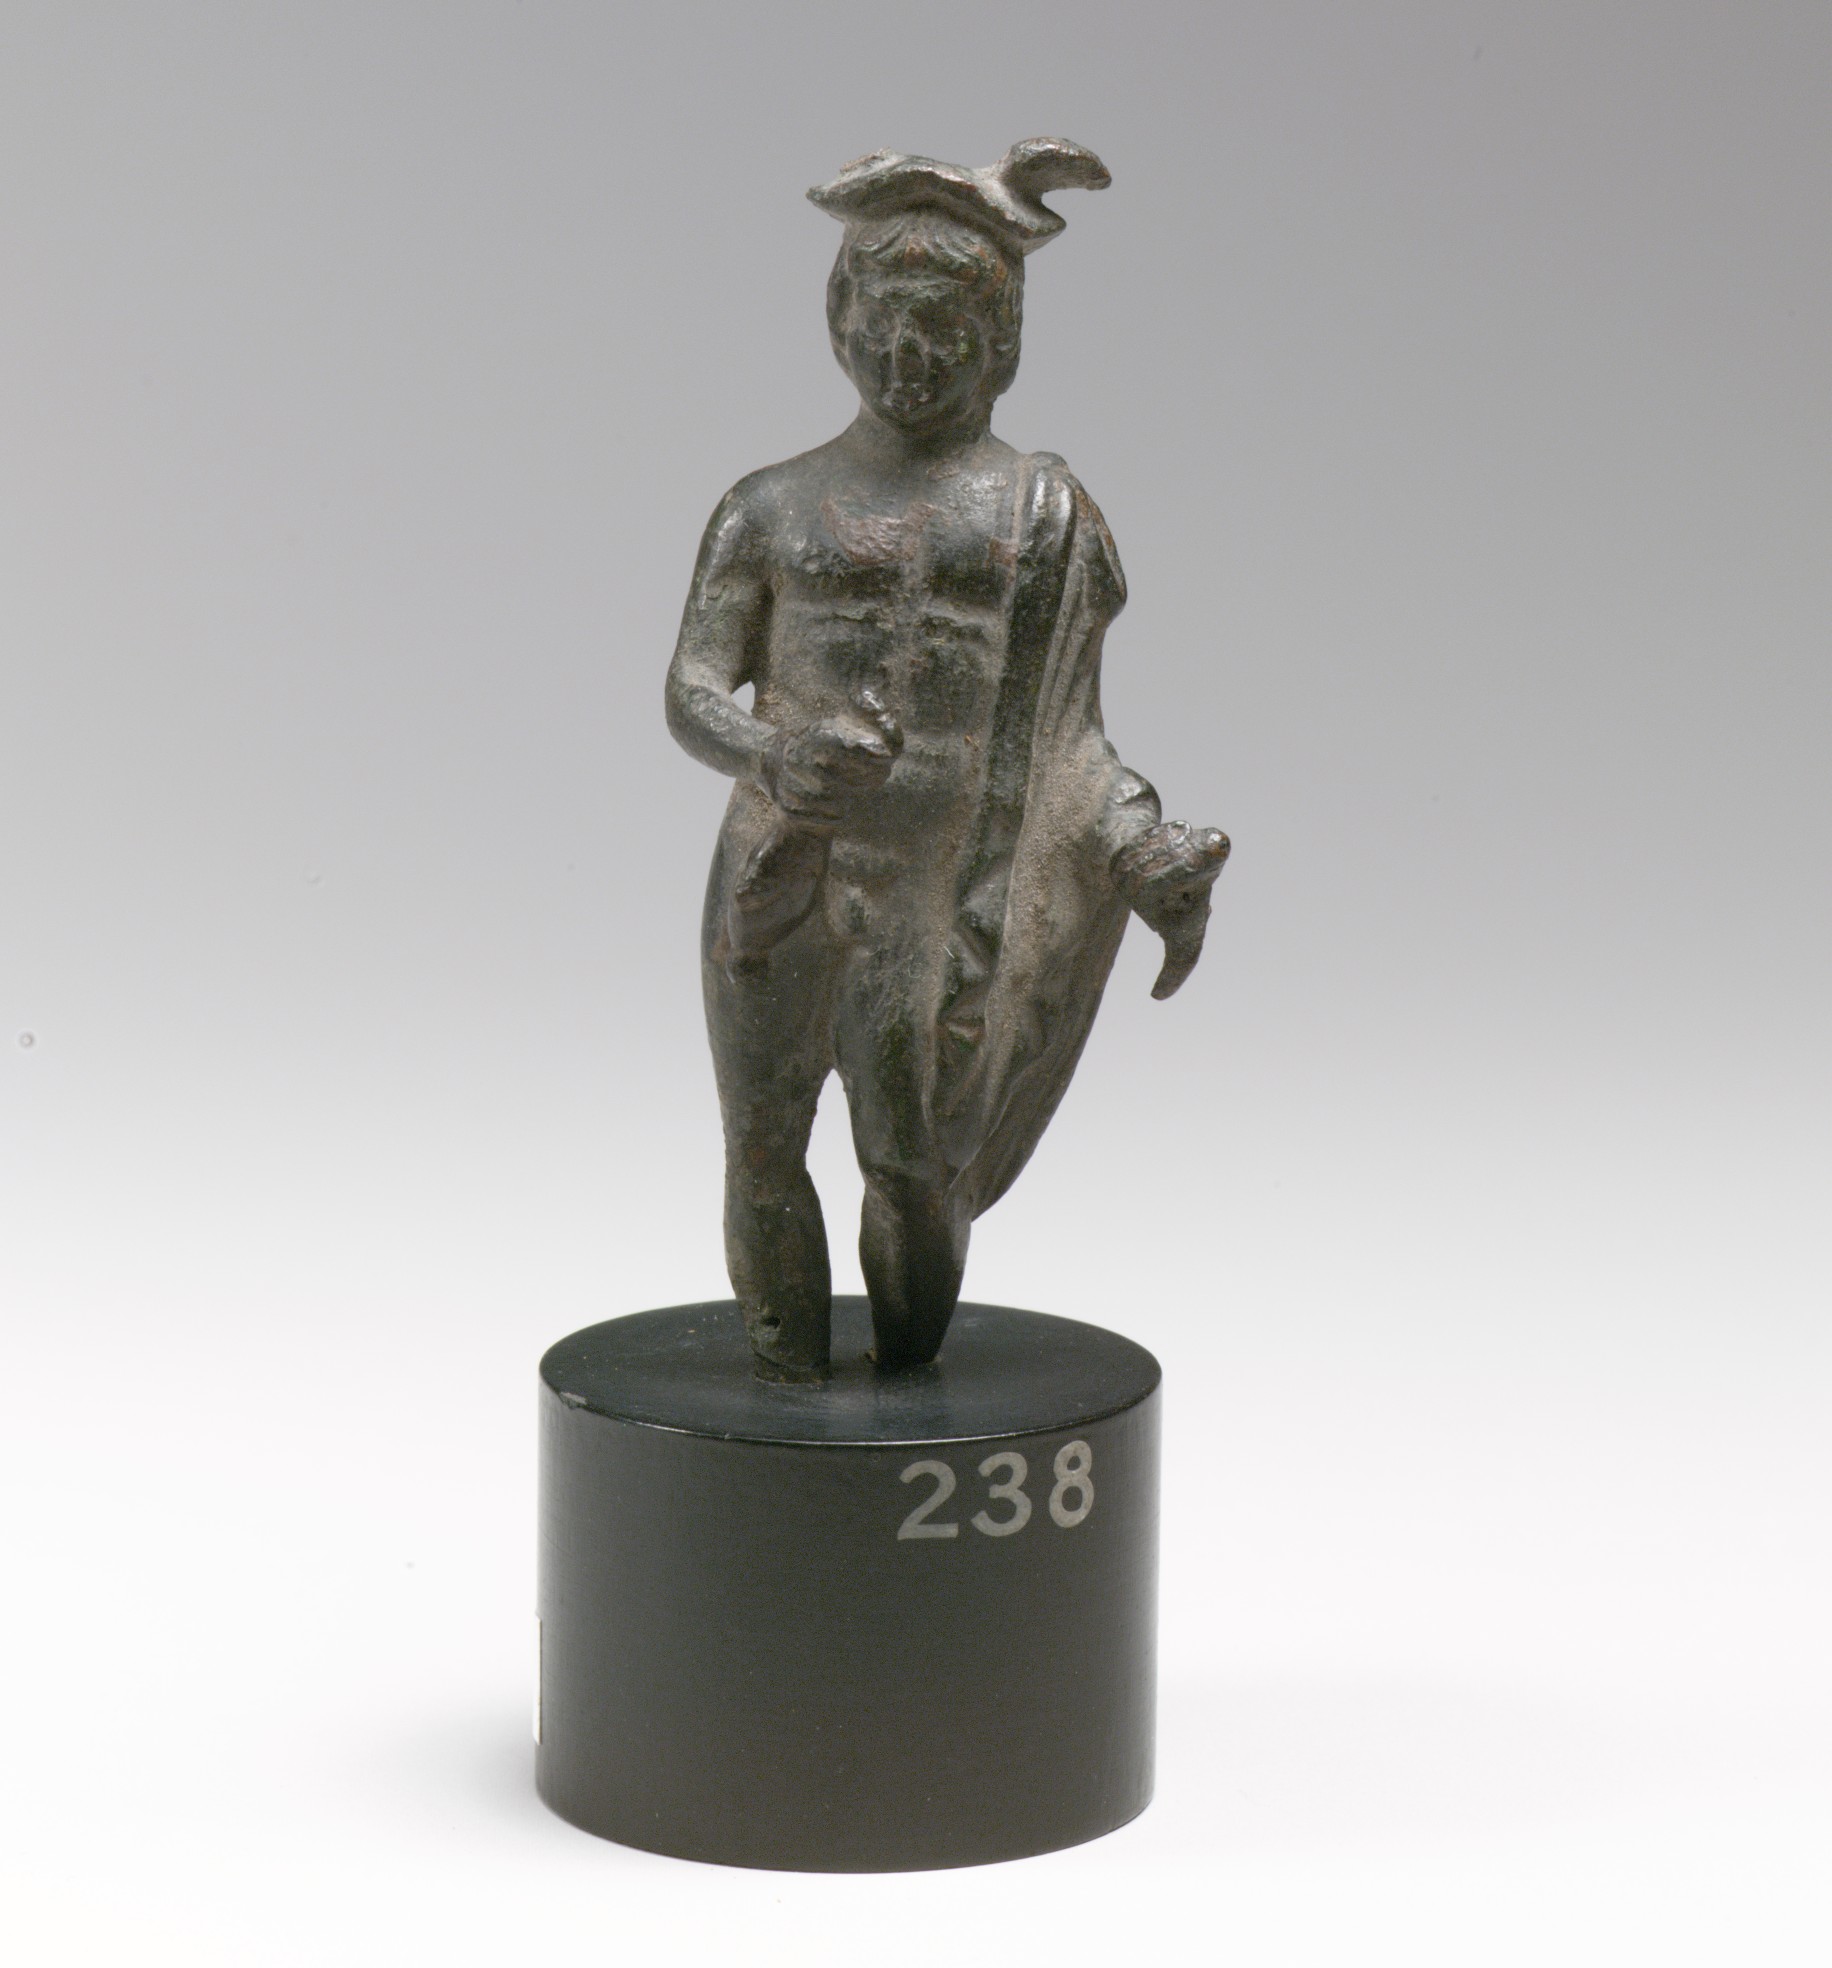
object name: statuette of hermes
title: Bronze statuette of Mercury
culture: roman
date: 1-200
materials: bronze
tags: mercury